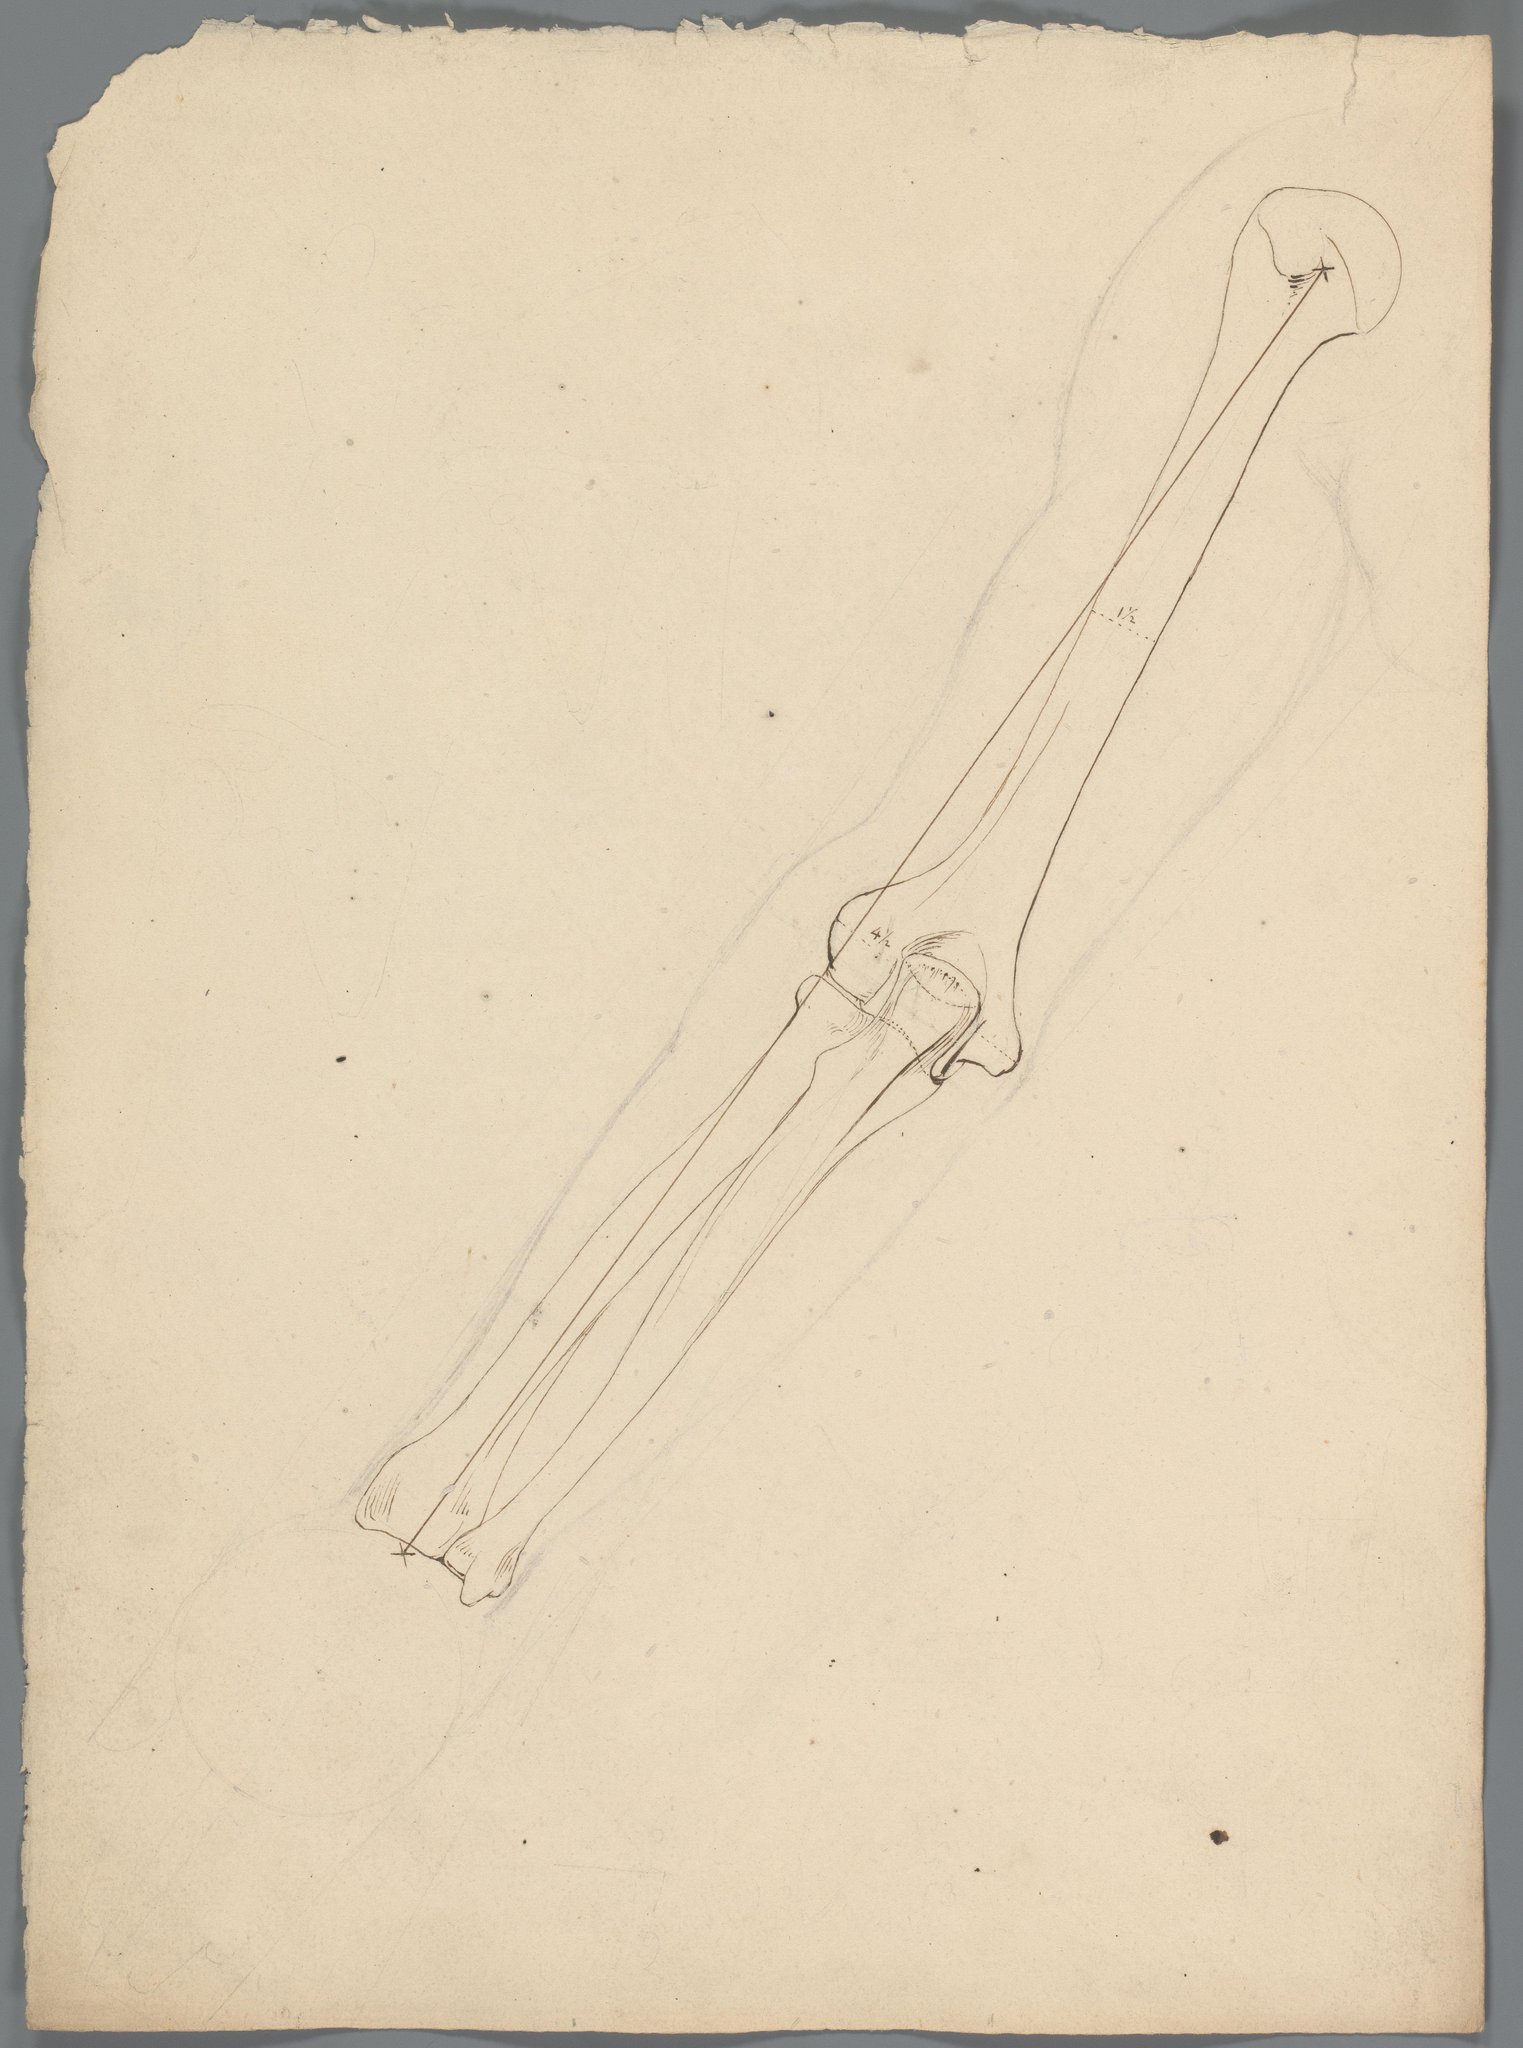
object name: drawing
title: Studie van de armbotten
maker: jacobus everhardus josephus van den berg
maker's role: draughtsman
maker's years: 1802-1861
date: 1812-1861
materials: ink, paper, pencil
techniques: pen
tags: bones of the arms